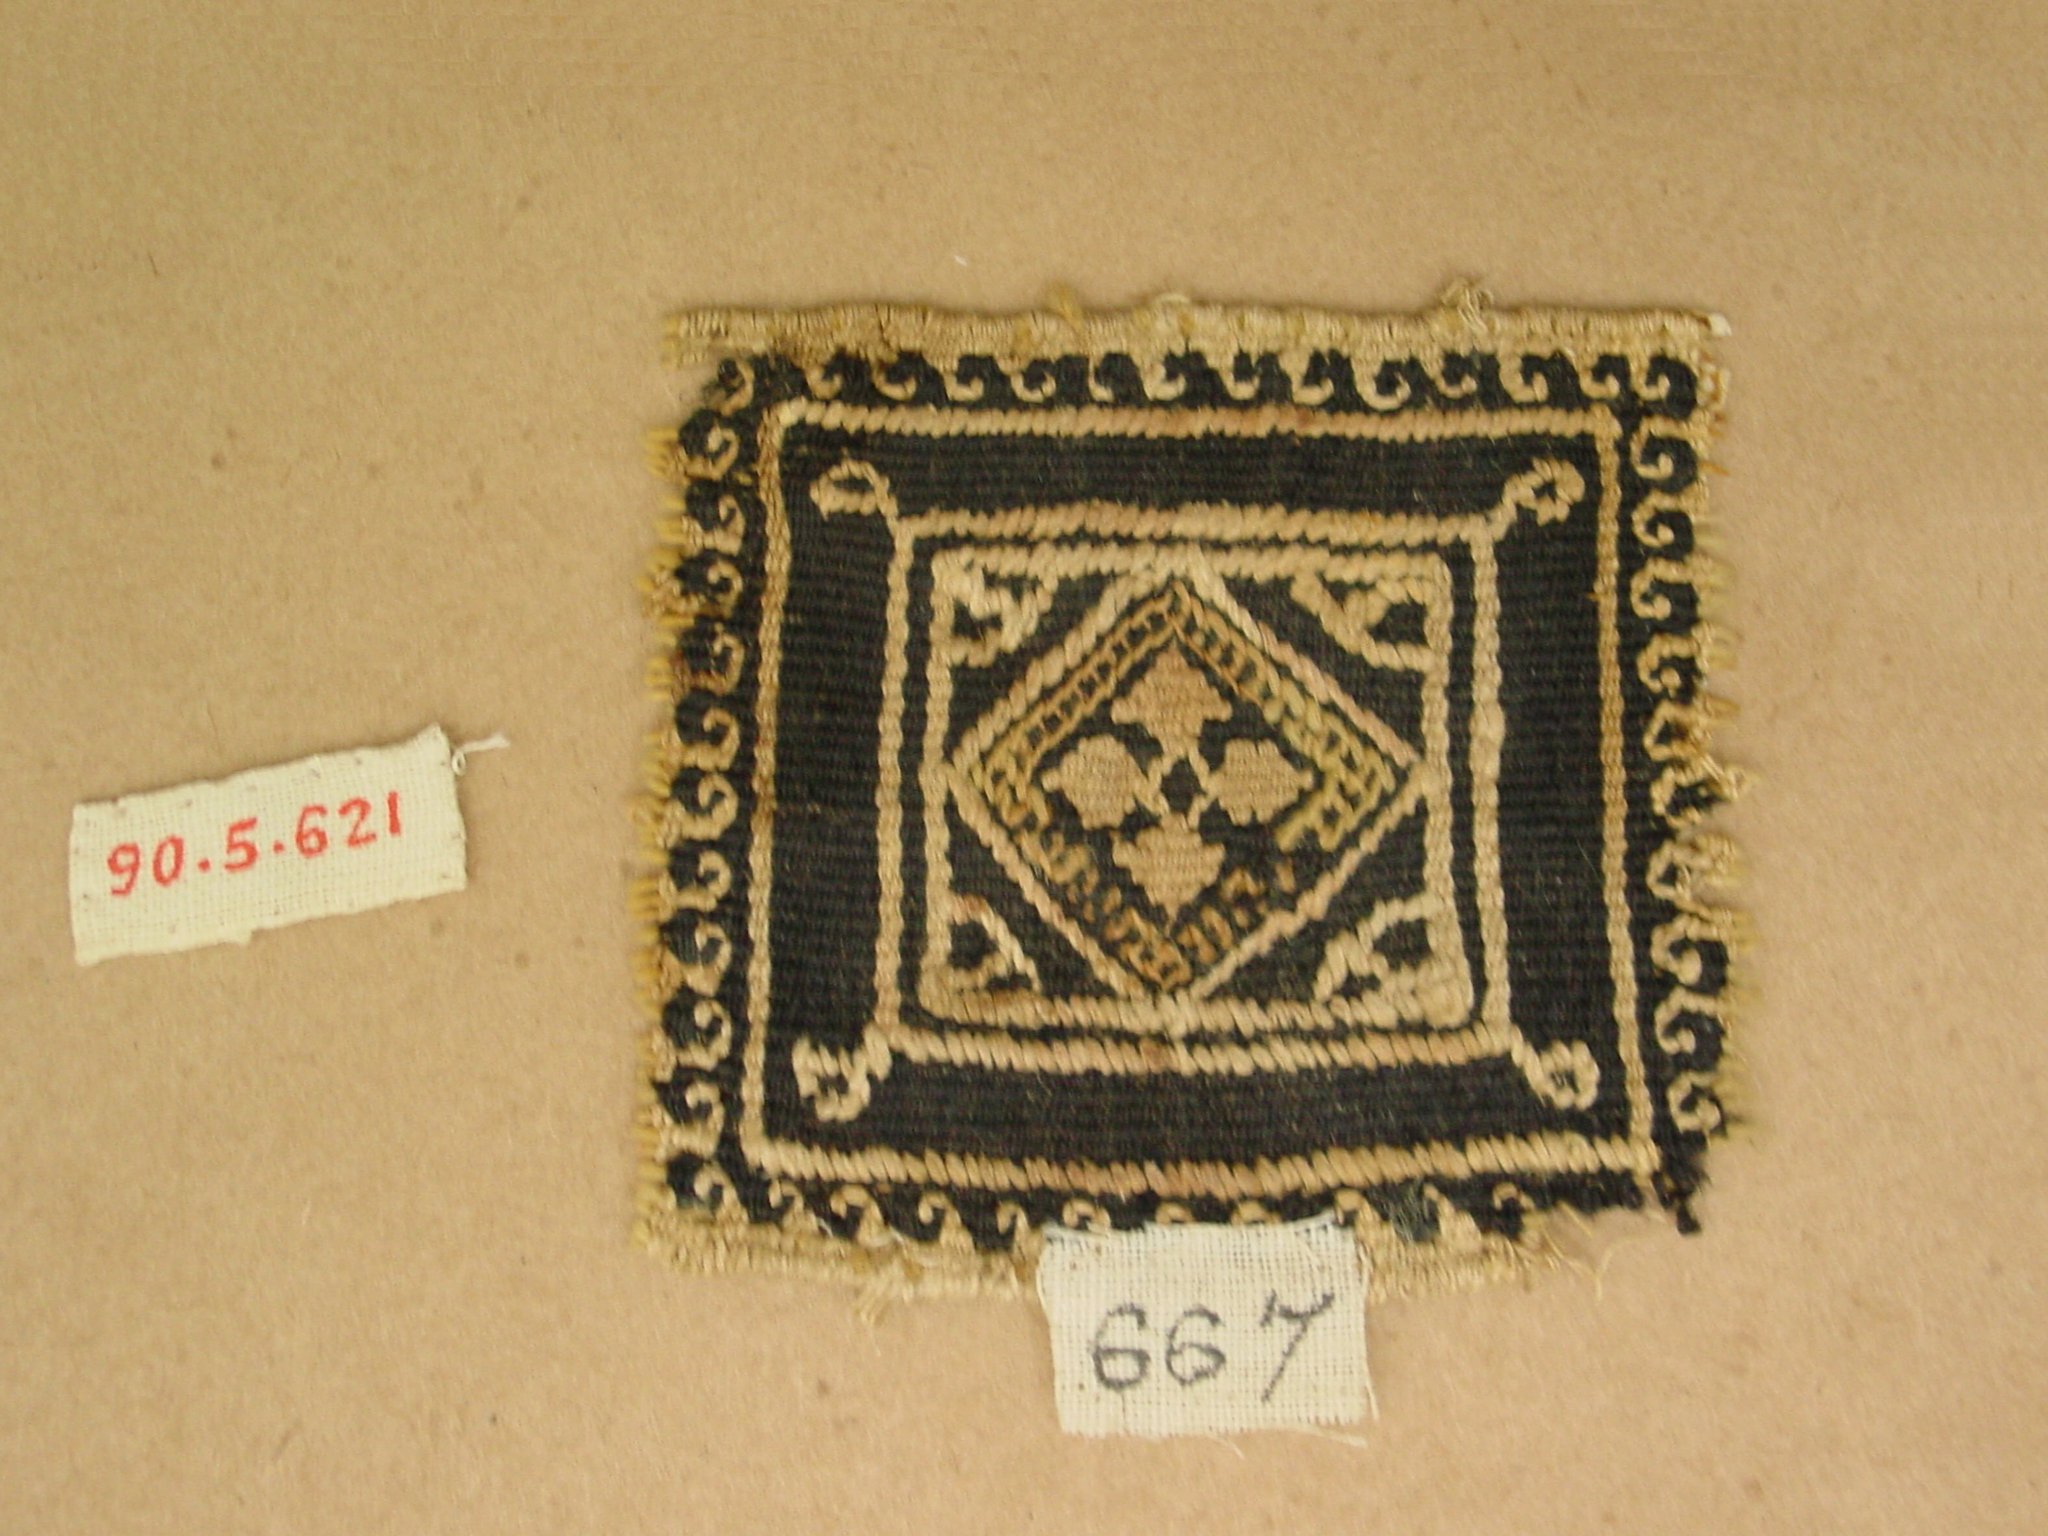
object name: textile fragment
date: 201-400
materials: linen, wool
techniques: weave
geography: egypt